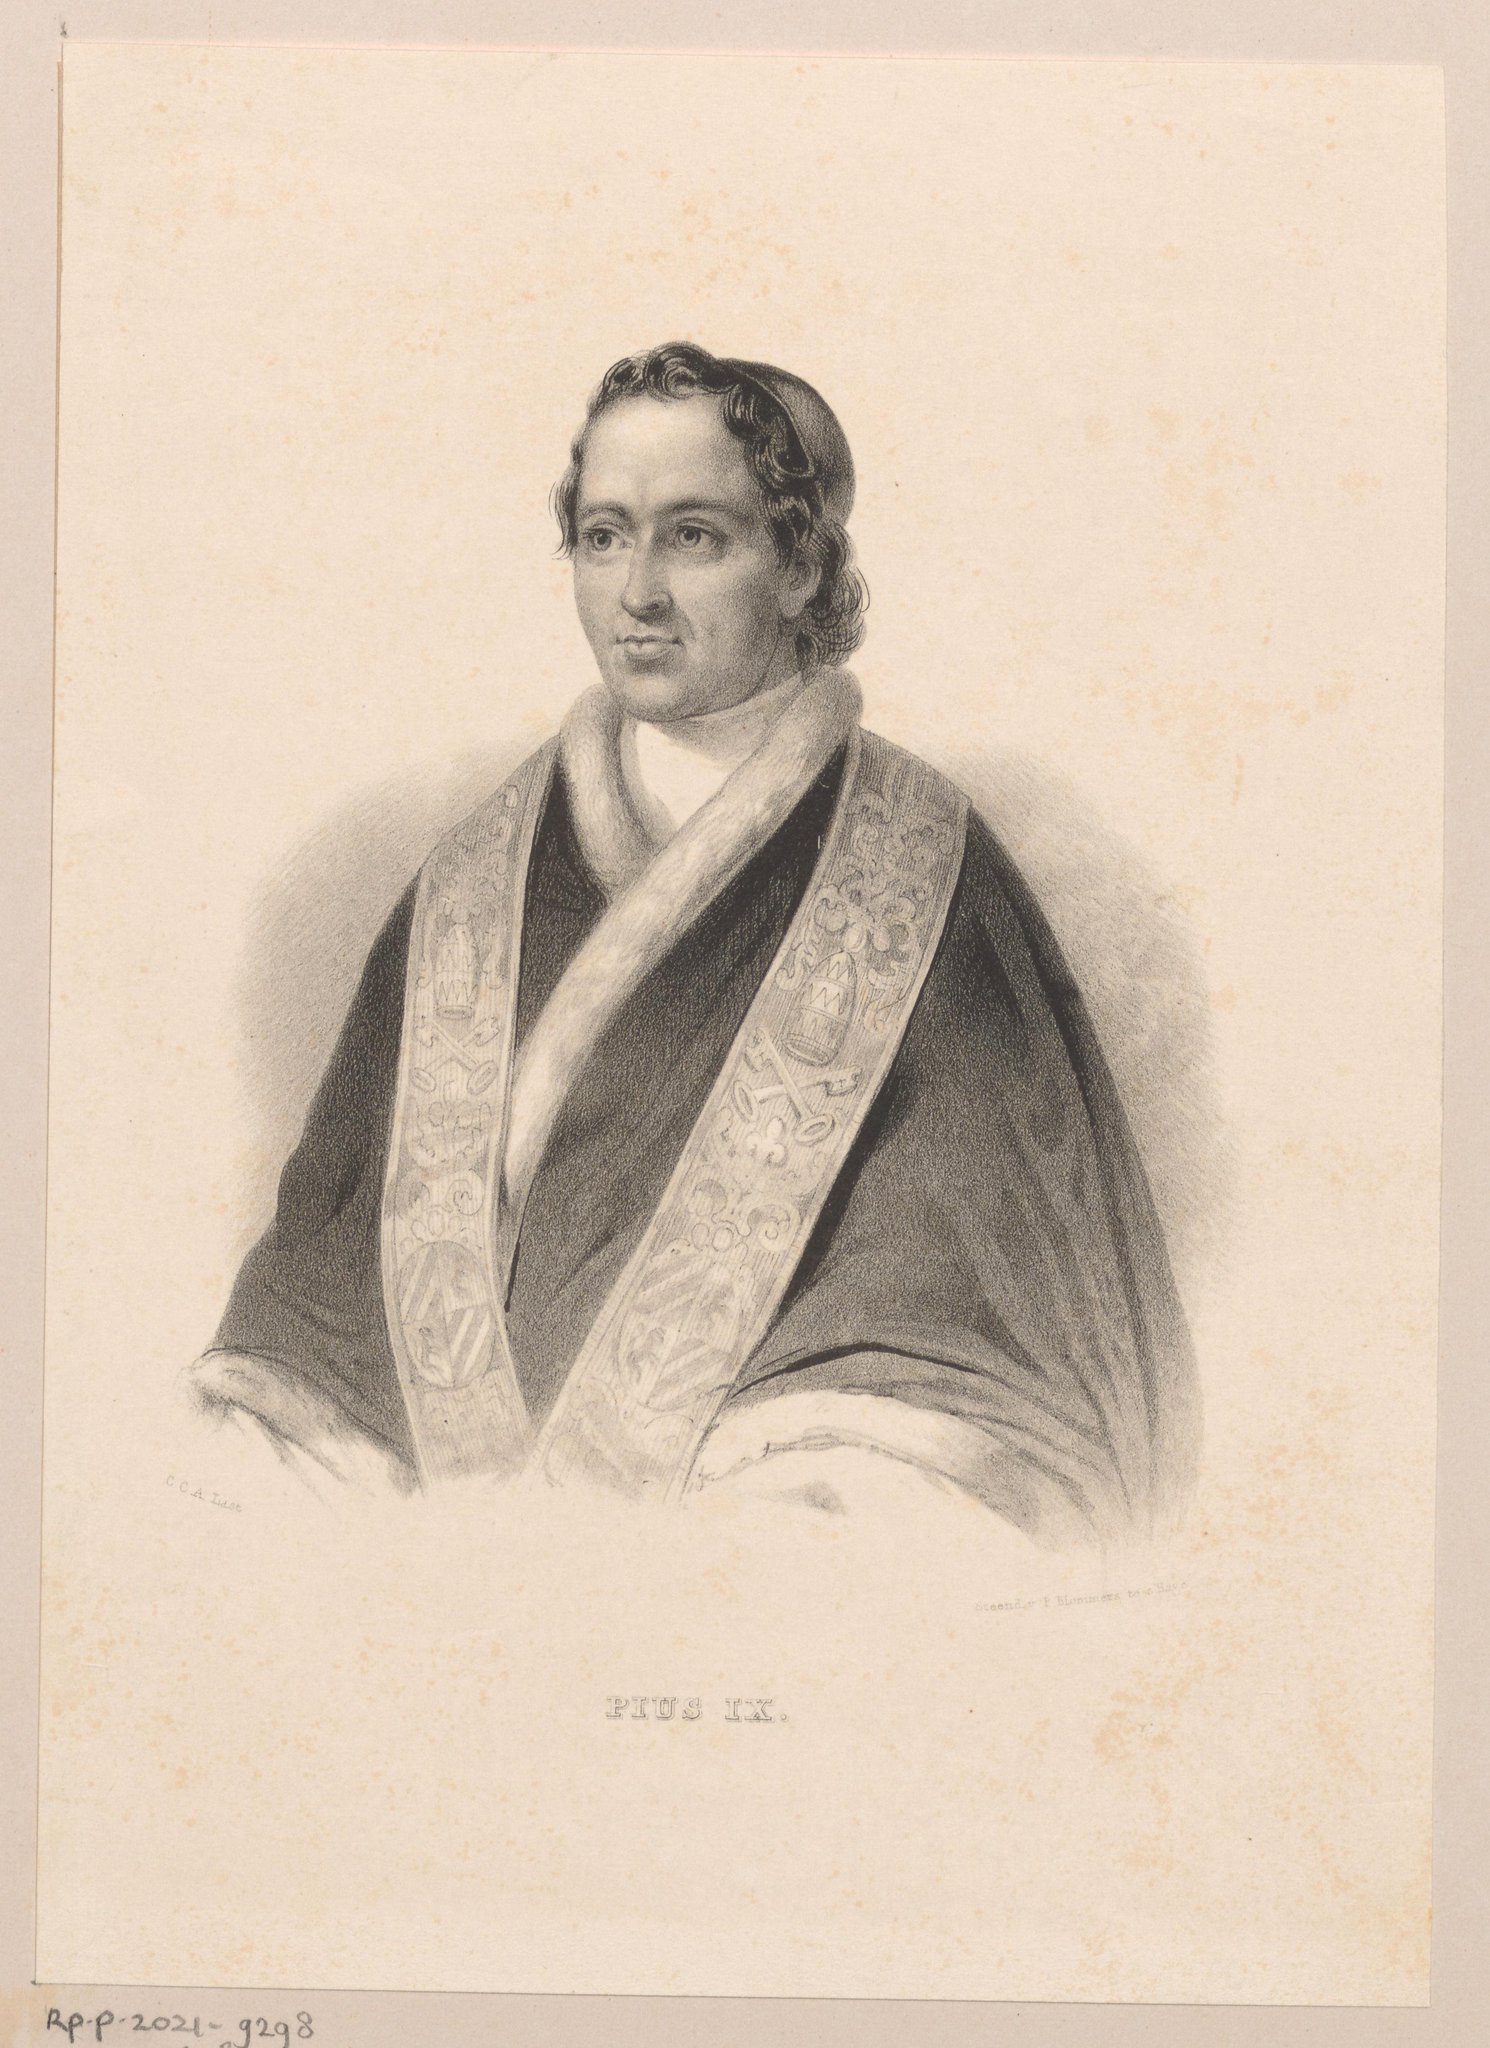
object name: print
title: Portret van paus Pius IX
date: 1846-1876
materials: paper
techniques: lithograph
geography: the hague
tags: rome, historical persons, pope